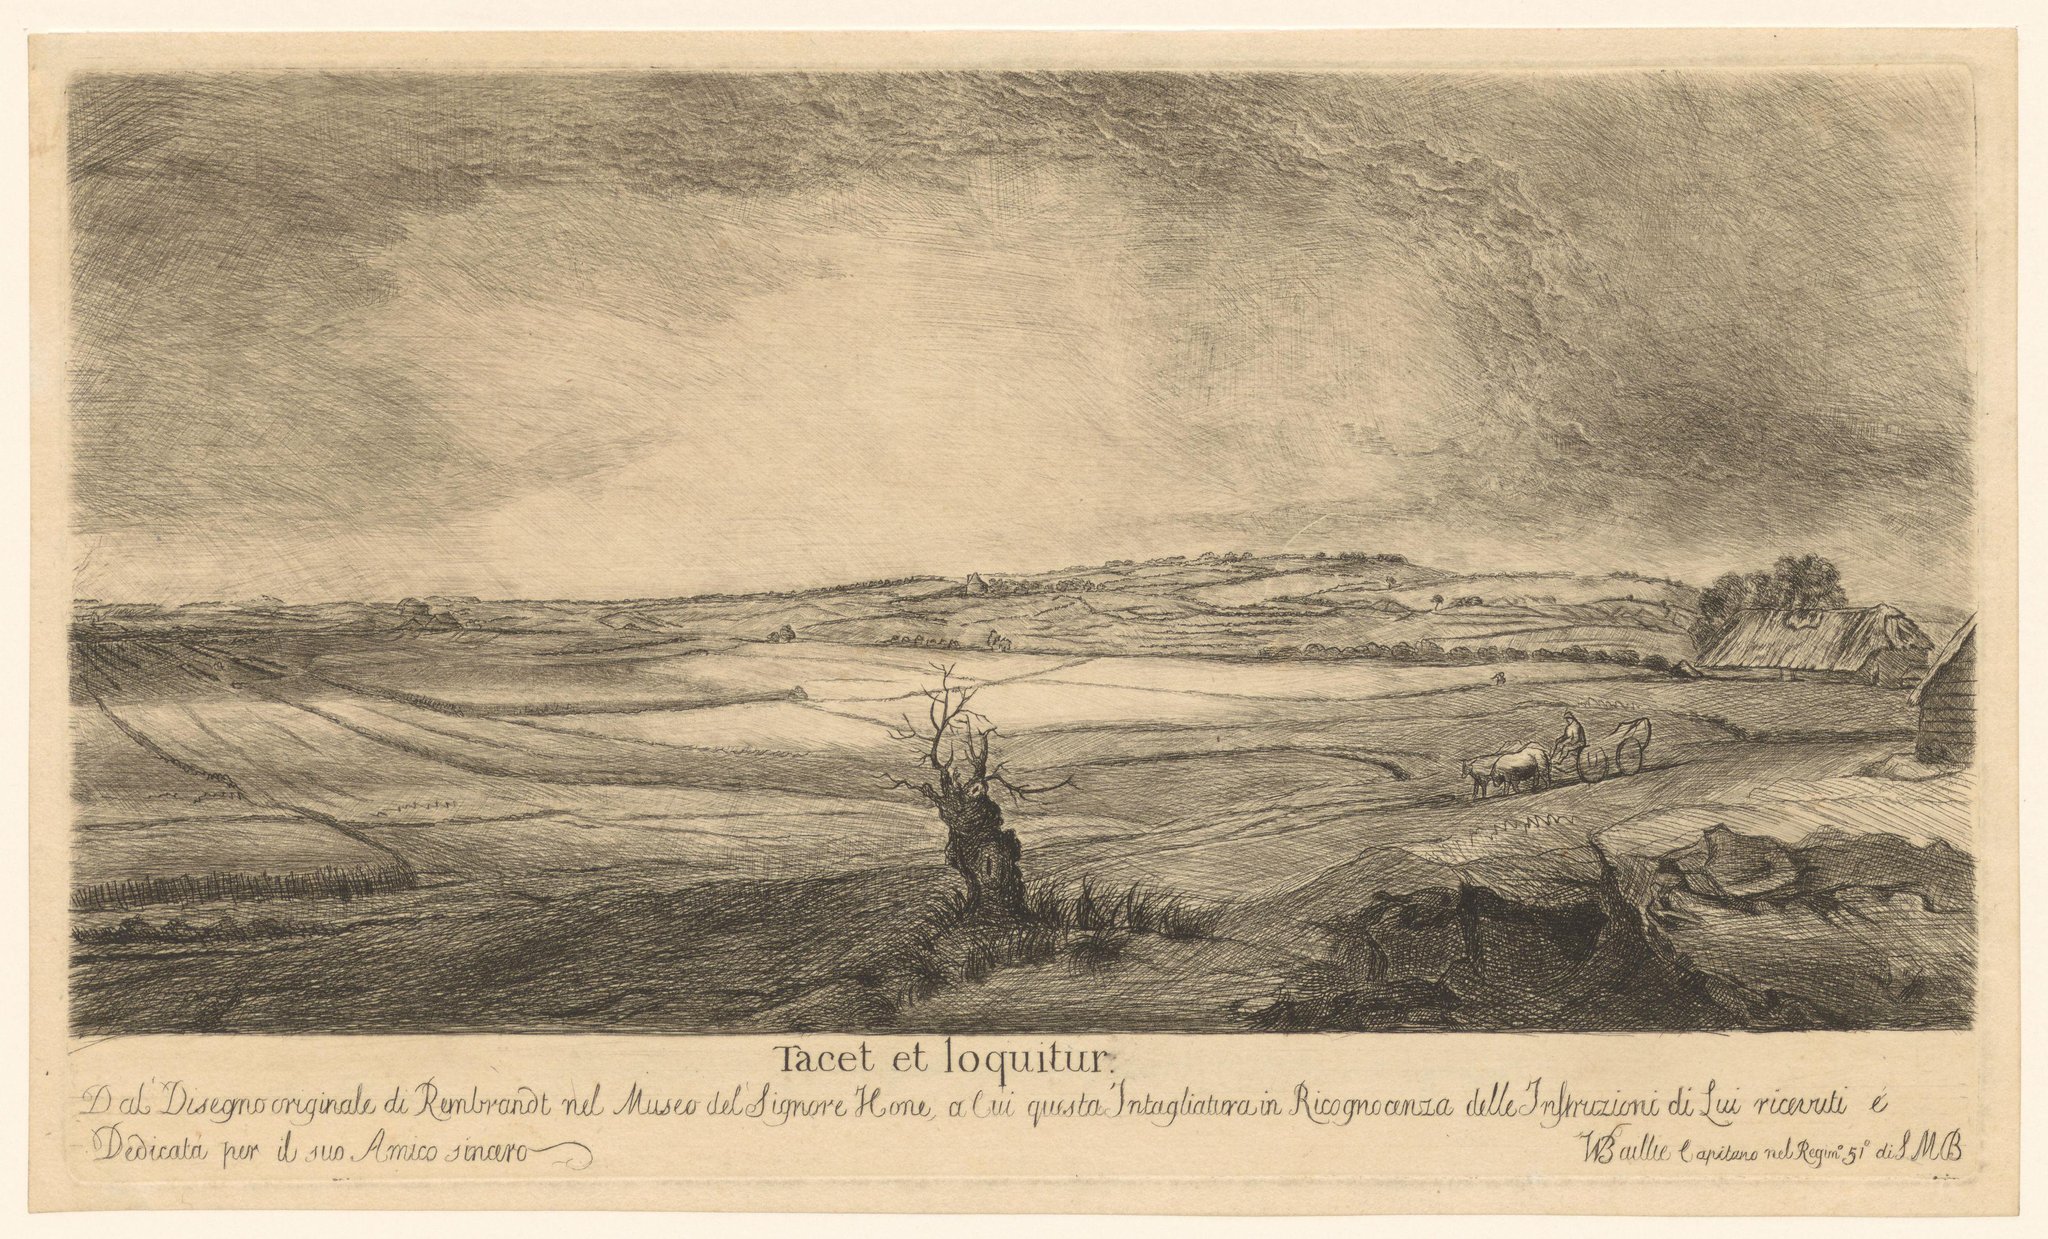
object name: print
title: Tacet et loquitur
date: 1760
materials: paper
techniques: etching, intaglio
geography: england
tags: cultivated land (+ landscape with figures, staffage)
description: Hoewel Baillie op zijn prent noemt dat deze naar een tekening van Rembrandt is gemaakt, schrijft Meyer dat de prent waarschijnlijk naar een tekening van Koninck is gemaakt.